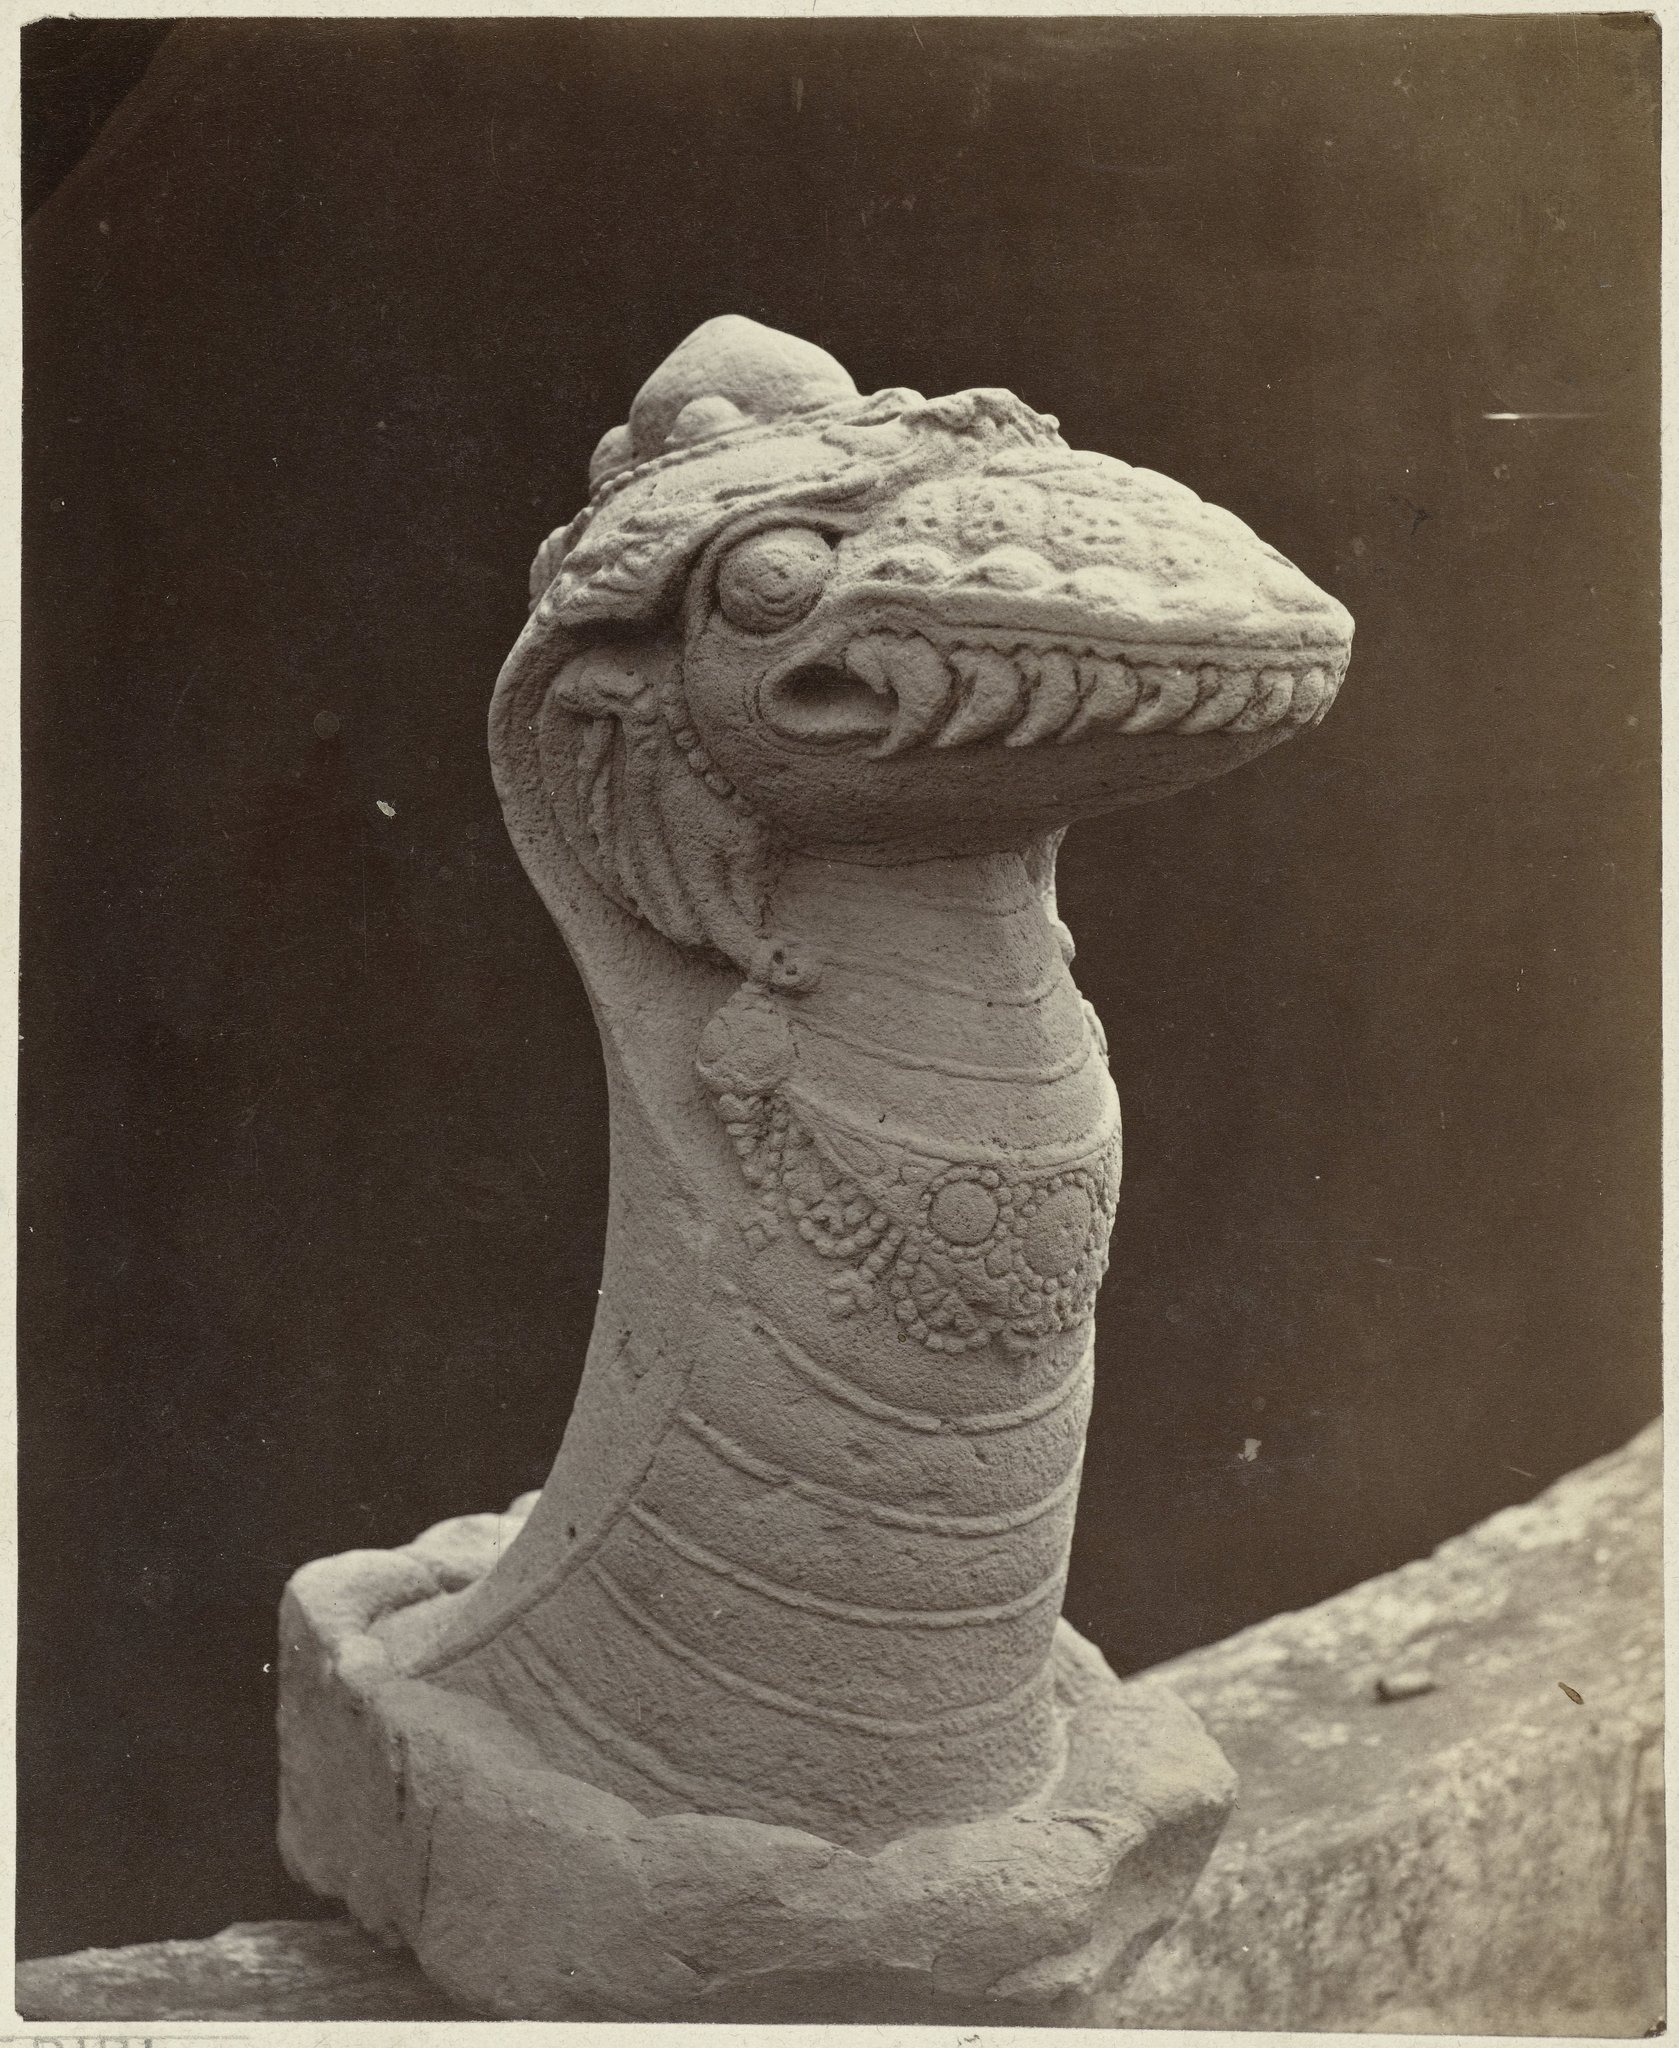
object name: photograph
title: Naga head (residential house) Kediri, Kediri-district, east Java province, 14th-15th century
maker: isidore kinsbergen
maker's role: fotograaf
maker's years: 1821-1905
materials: cardboard, paper, photographic support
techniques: albumen print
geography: java